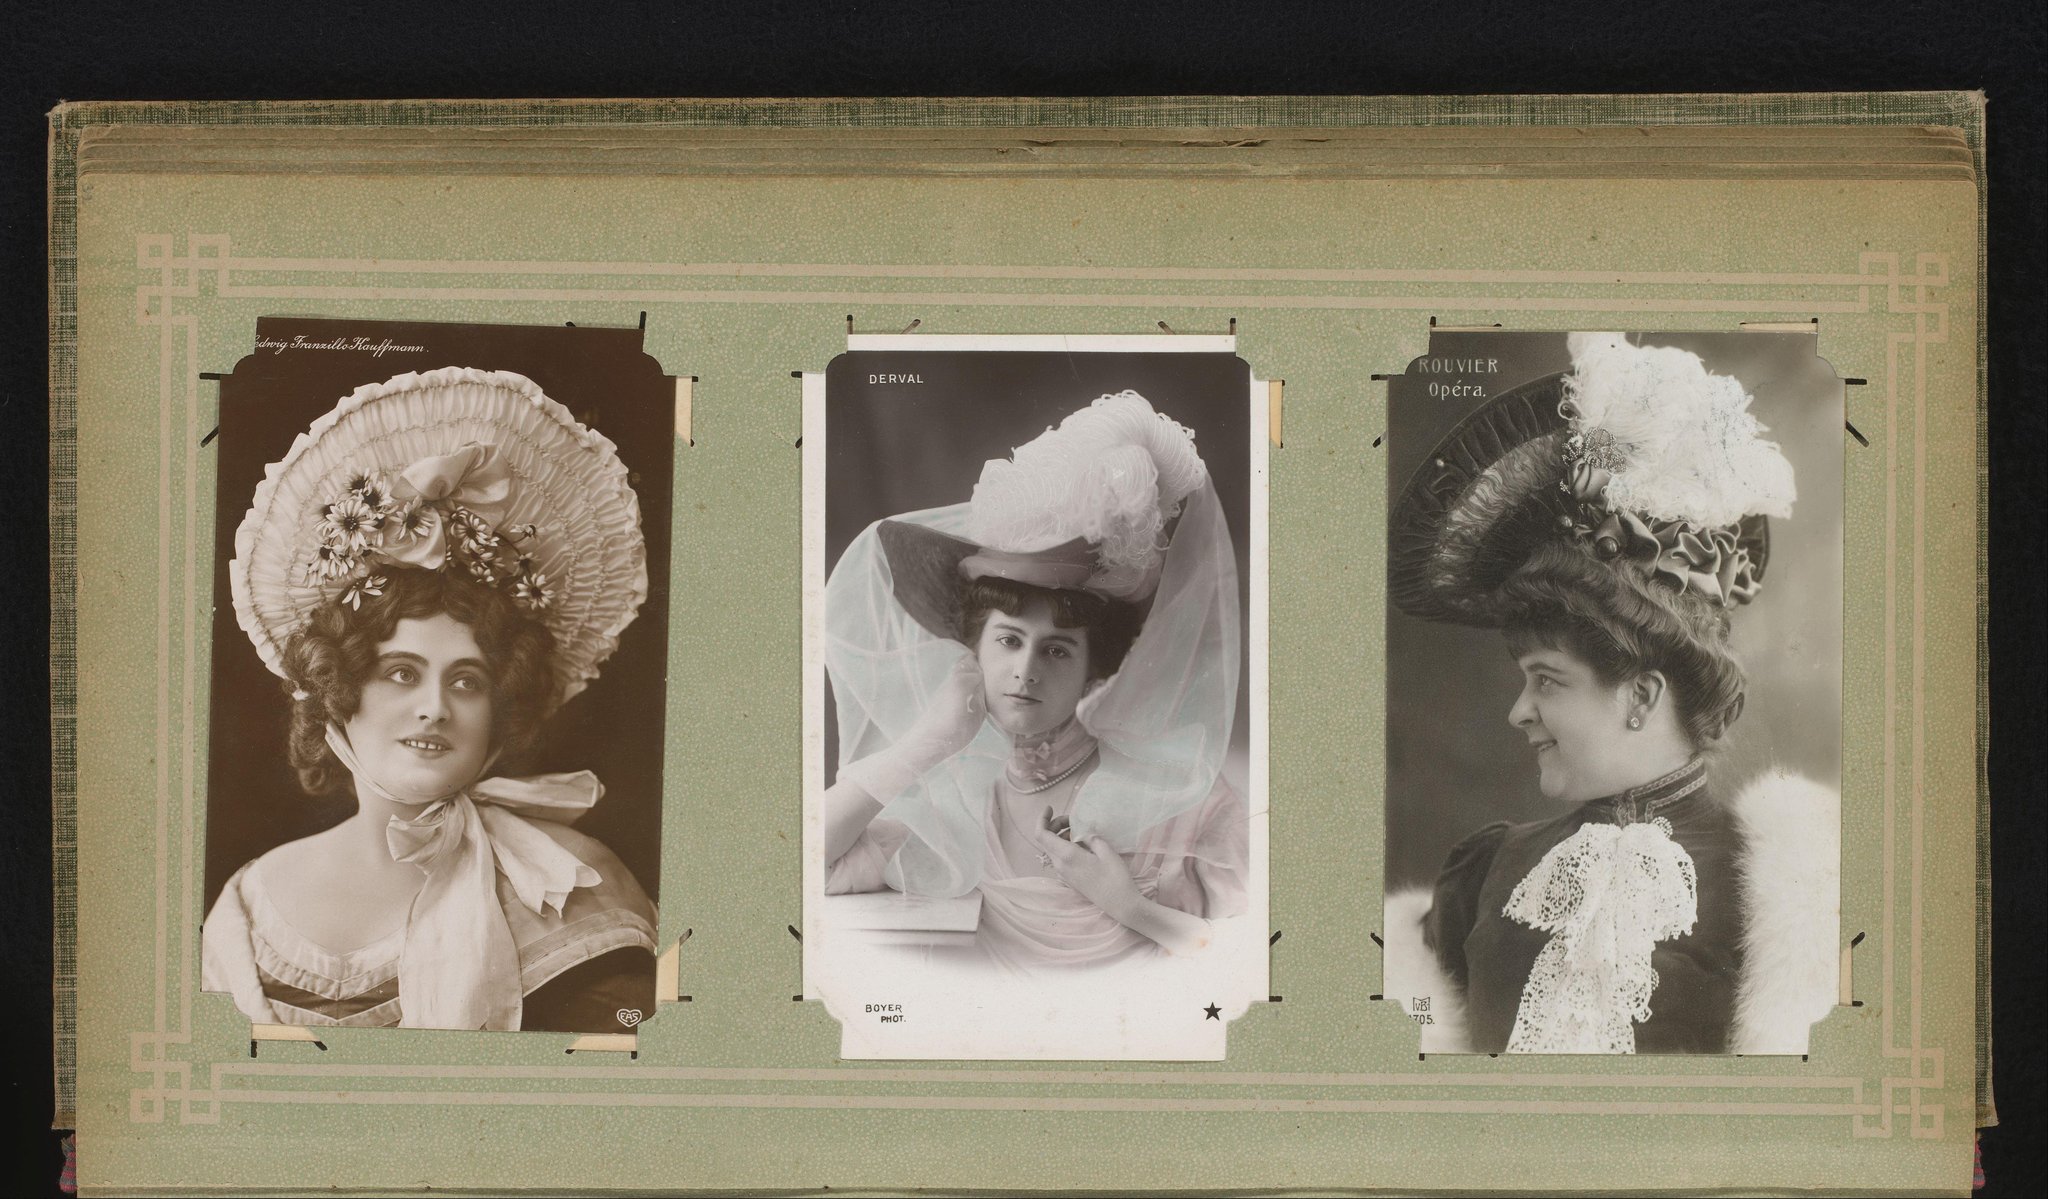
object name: ansichtkaart, prentbriefkaart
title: Drie portretten van actrices, onder wie Hedwig Francillo-Kauffmann en Marie Louise Derval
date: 1900-1930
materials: cardboard, photographic support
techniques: gelatin silver print, hand coloring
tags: vienna, historical persons - bb - woman, portrait of actor, actress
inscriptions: monogram: ‘vB’, monogram: ‘EAS’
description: Deze foto's maken deel uit van een album.